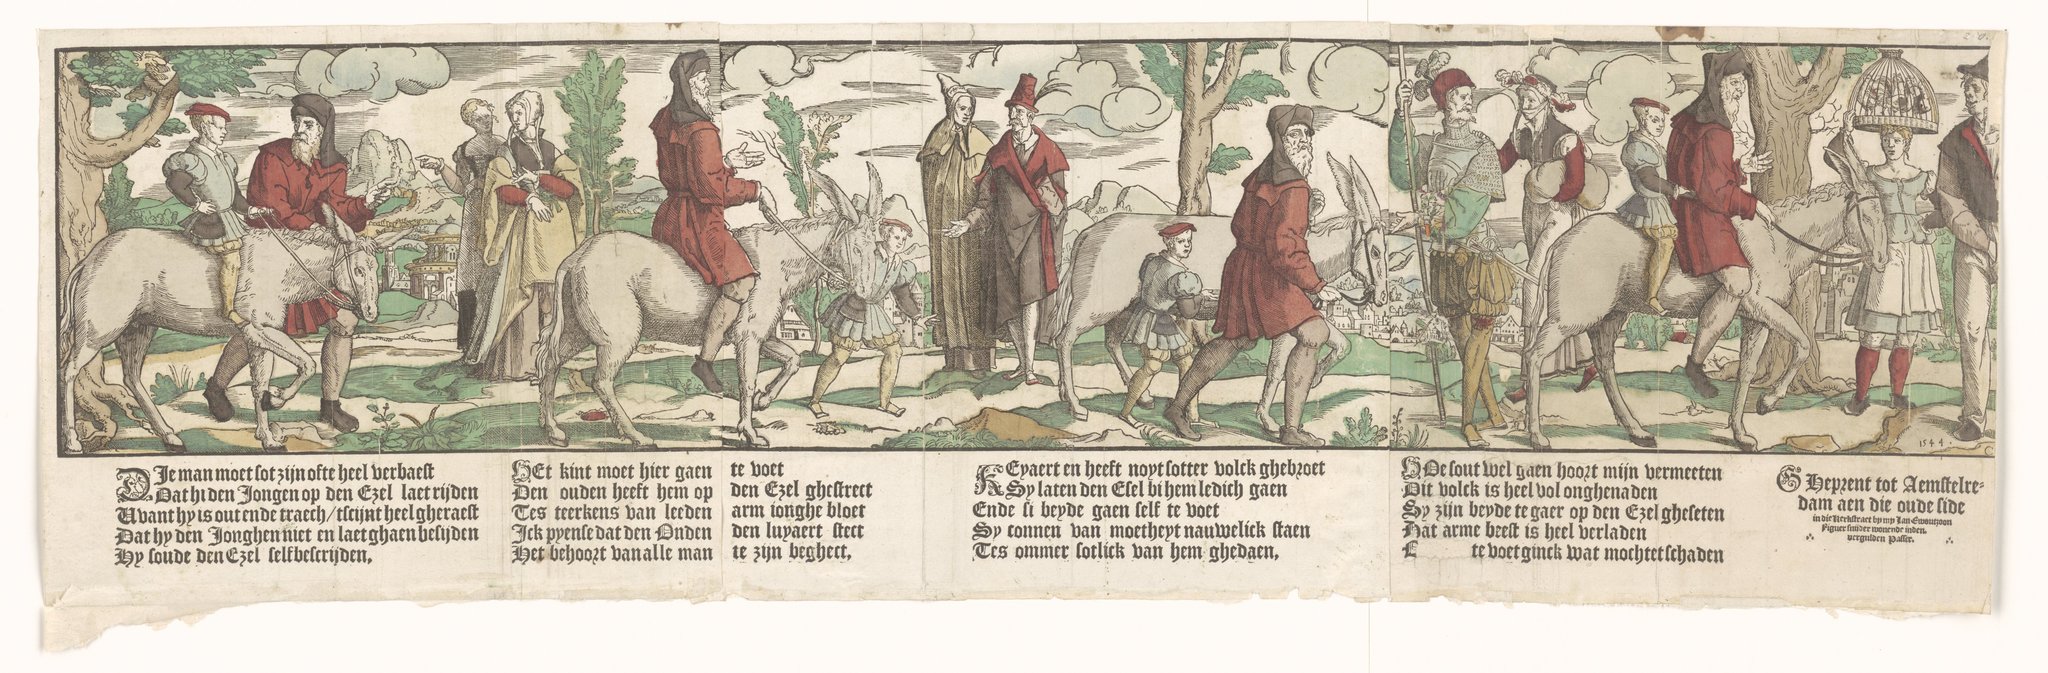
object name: print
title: Fabel van de vader, de zoon en de ezel (drie van de vier blokken)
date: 1544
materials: paper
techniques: brush, hand coloring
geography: amsterdam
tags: ass, donkey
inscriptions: date